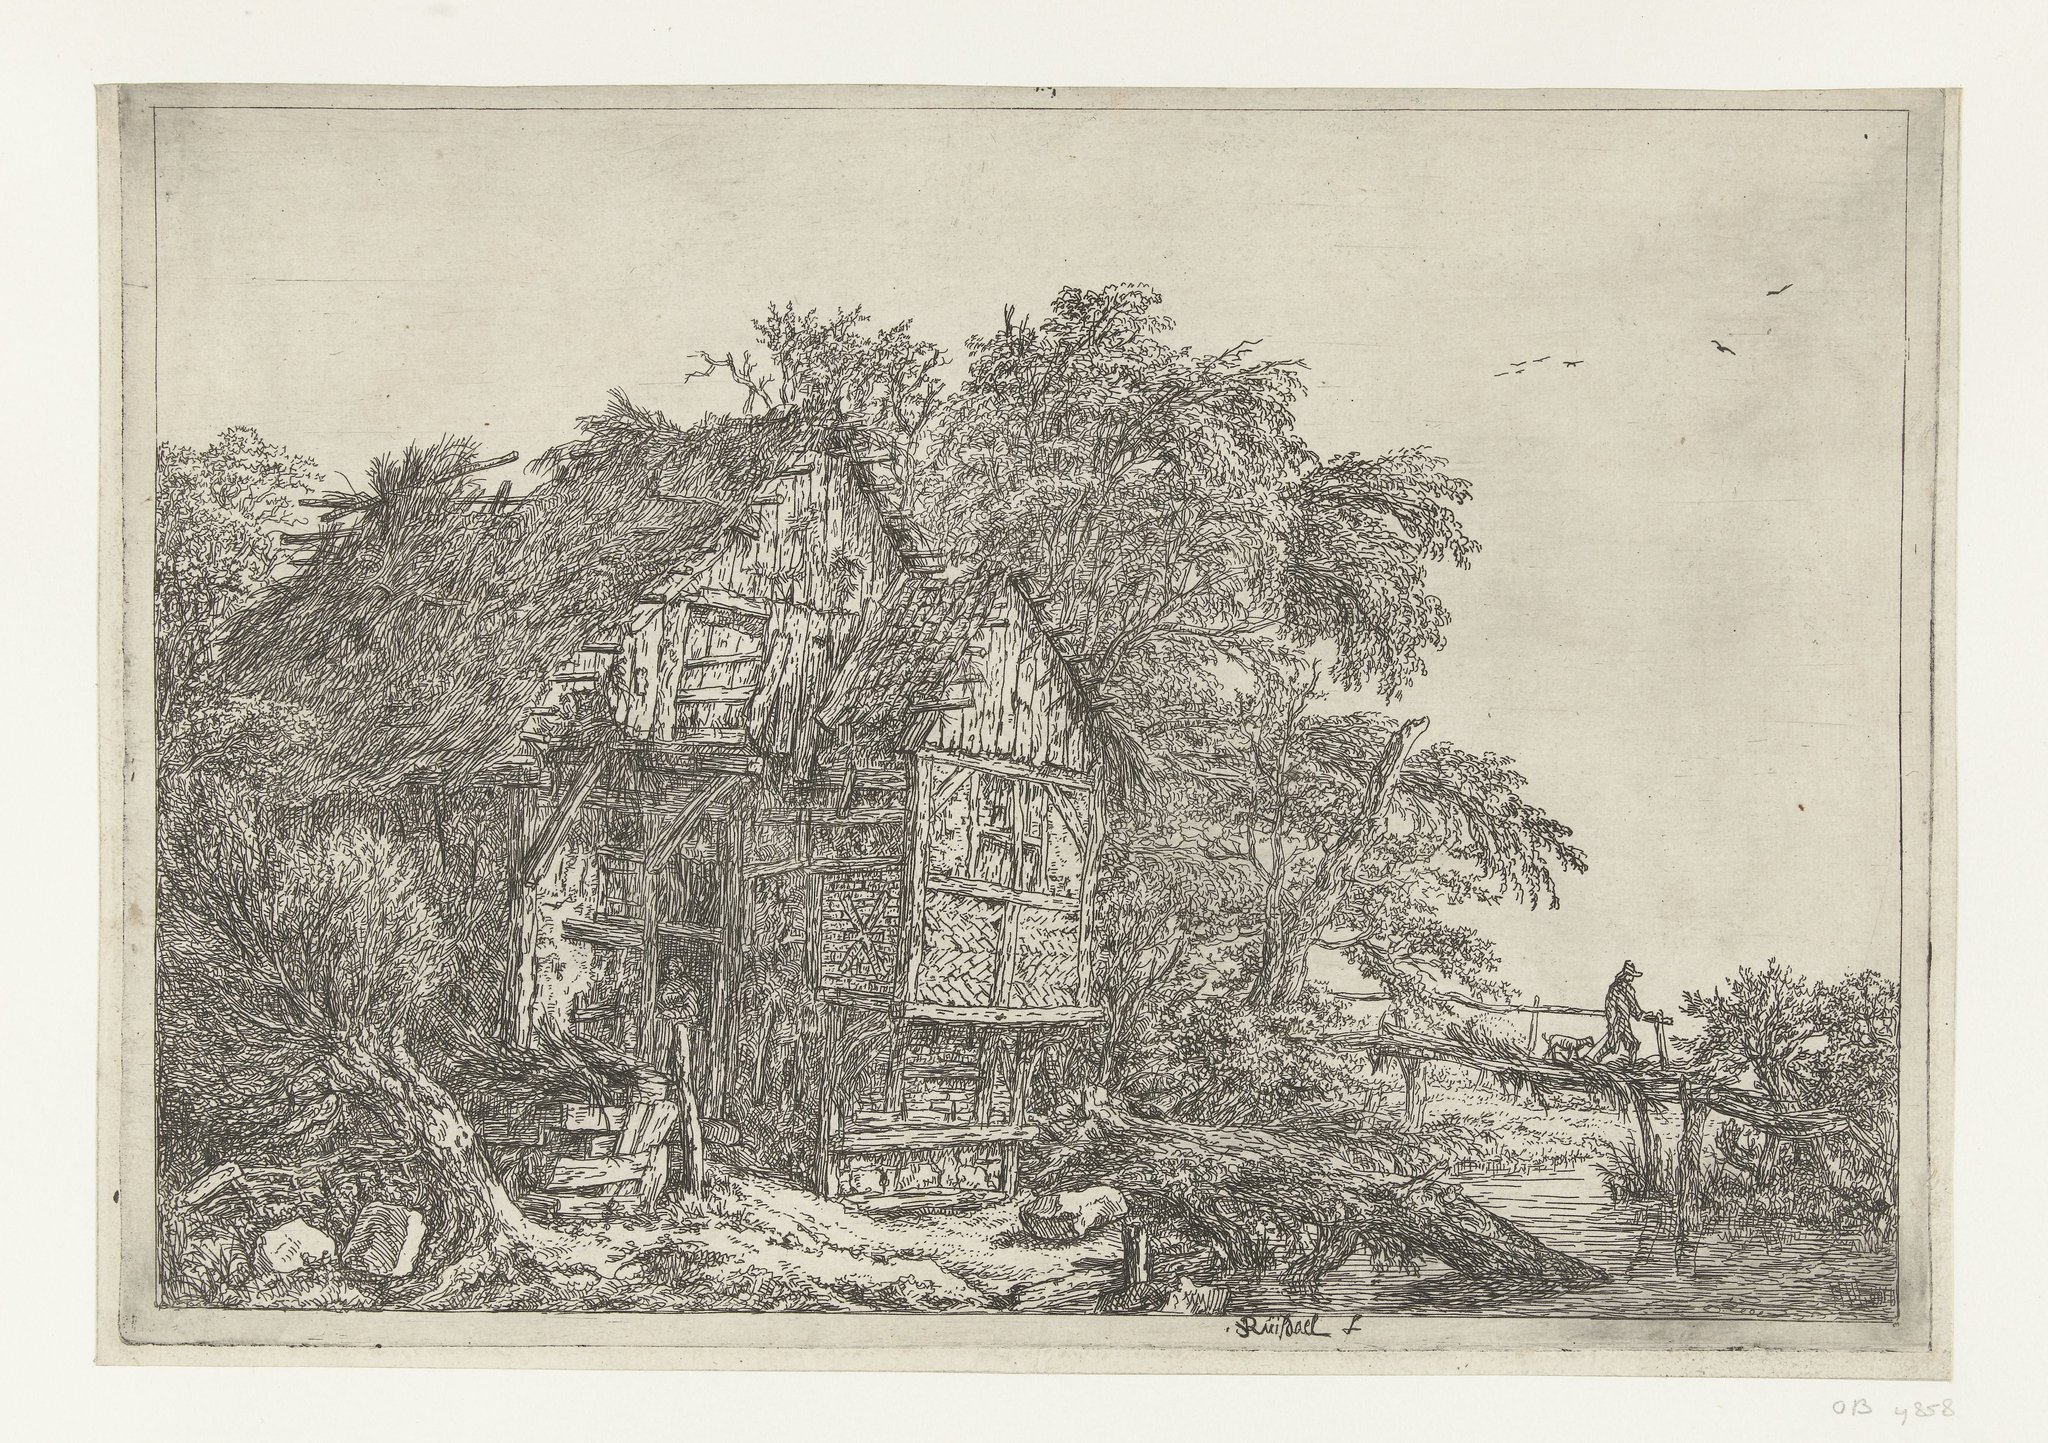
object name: print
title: De kleine brug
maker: jacob isaacksz van ruisdael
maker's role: draughtsman, painter, print maker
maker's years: 1628-1682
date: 1650-1655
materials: paper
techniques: etching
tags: cottage, bridge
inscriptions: collector's mark: Lugt 240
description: Een vervallen vakwerkhuis aan de oever. Over het water een bruggetje met een man en een hond.